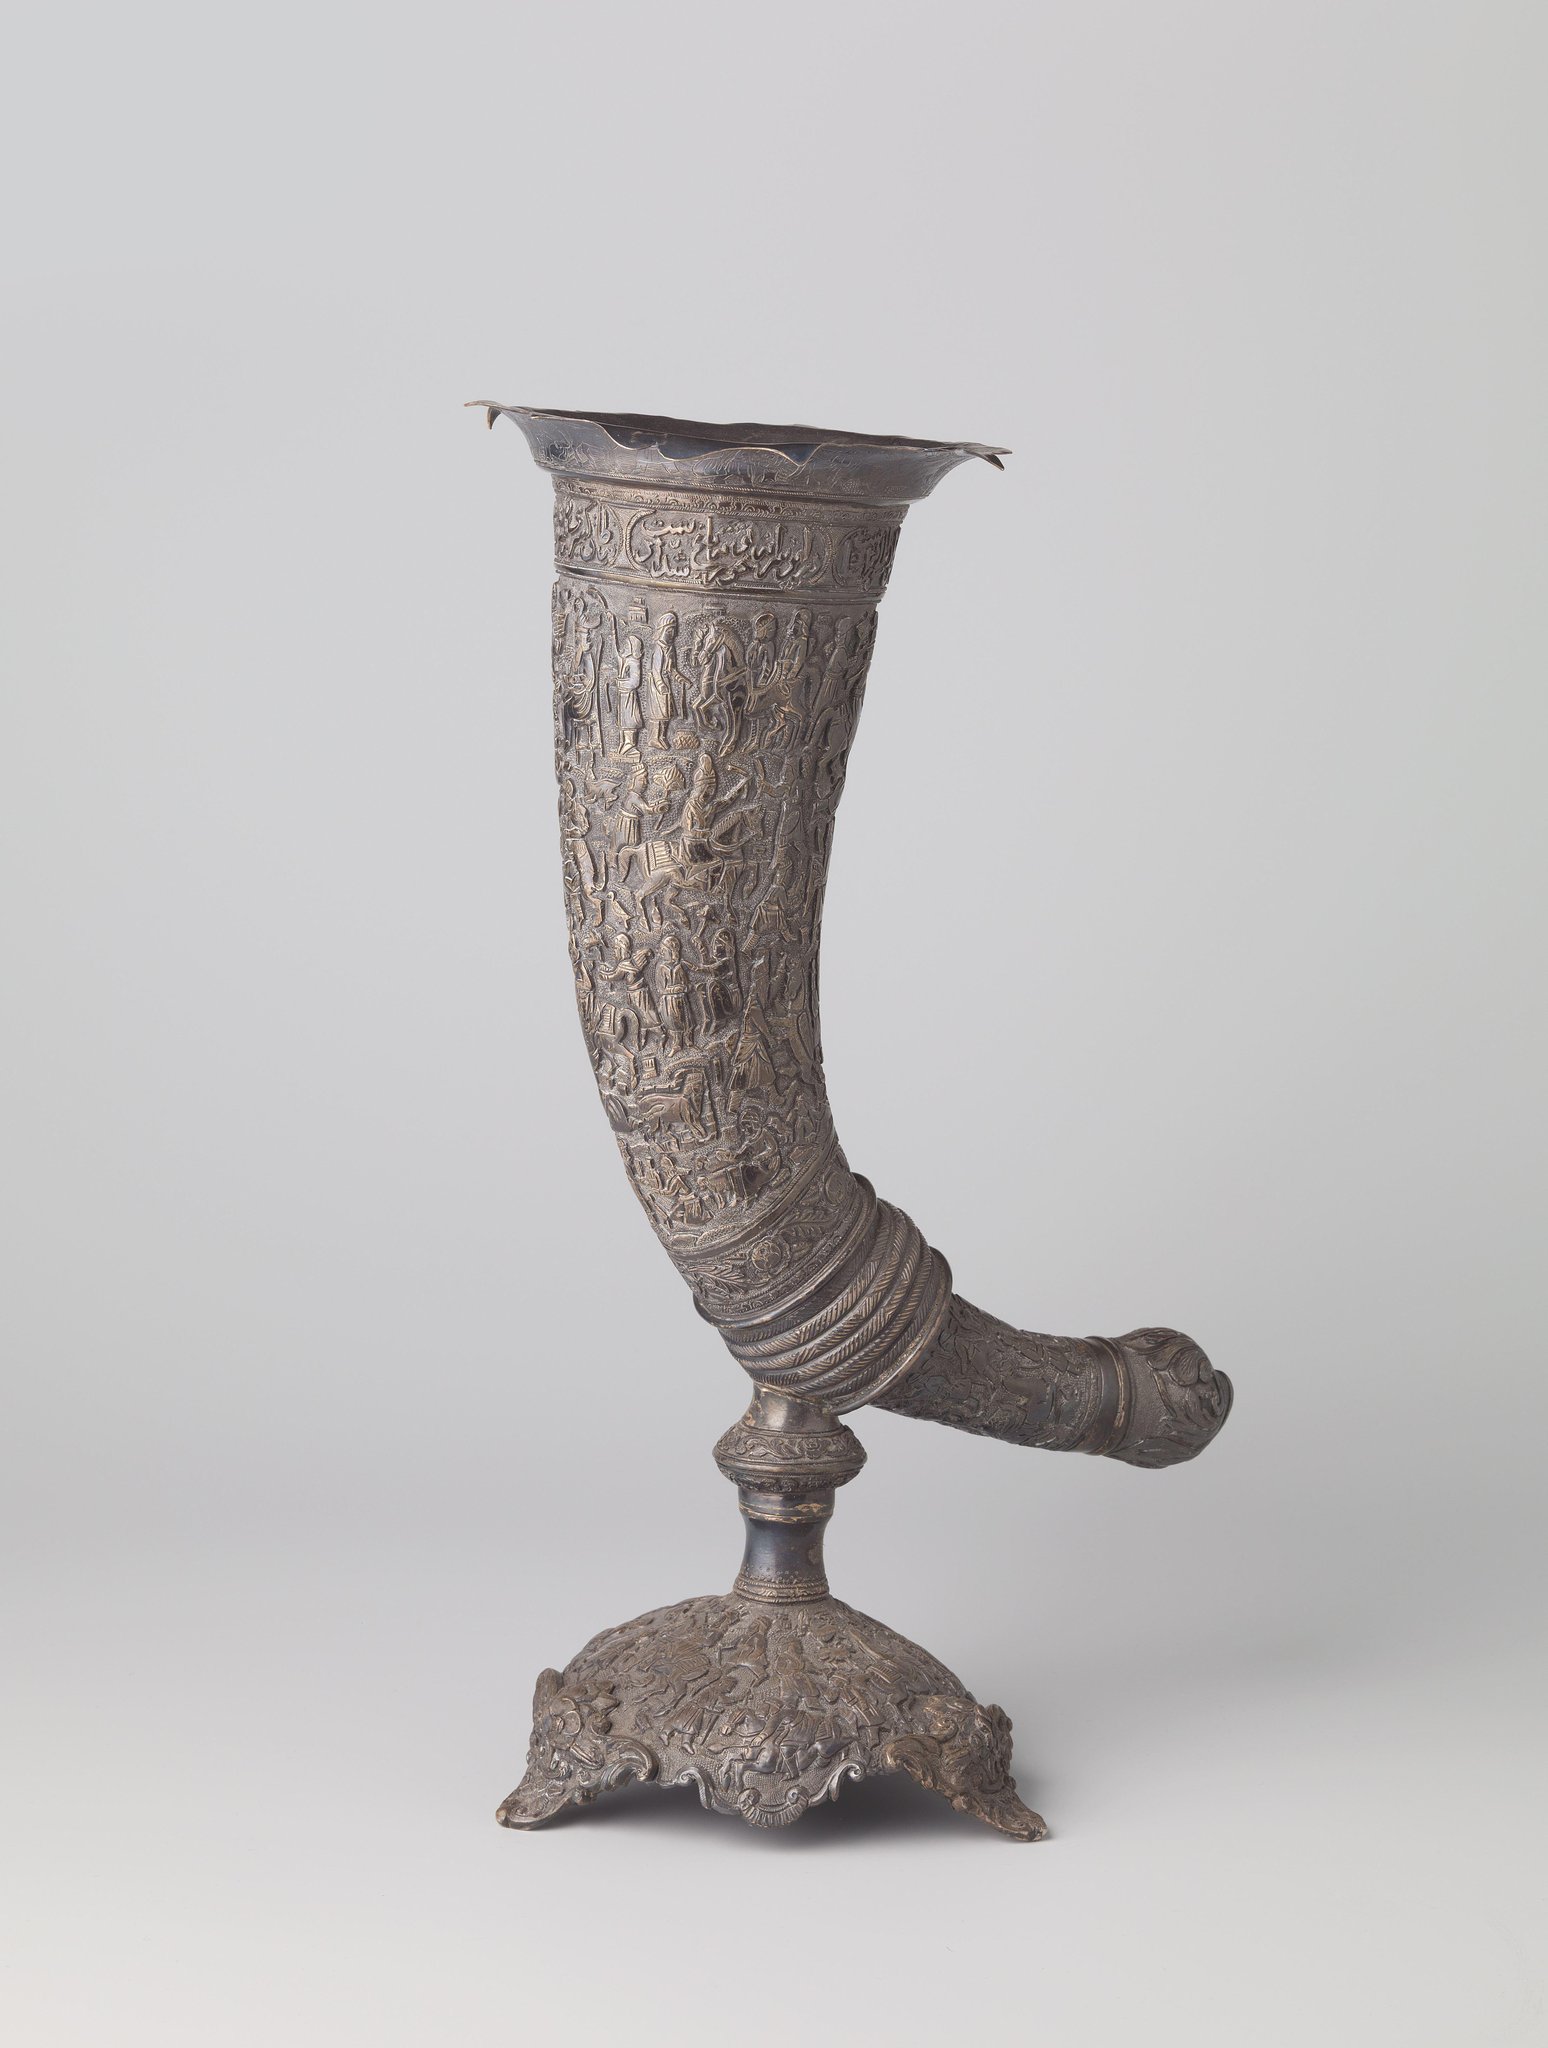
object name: drinking horn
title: Drinkhoorn op voetstuk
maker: Anonymous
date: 1850-1875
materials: silver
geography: iran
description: Hoge drinkhoorn van zilver, het oppervlak versierd met verschillende friezen en een inscriptie in het Arabisch, het voetstuk is versierd met bloemen en rocailles.